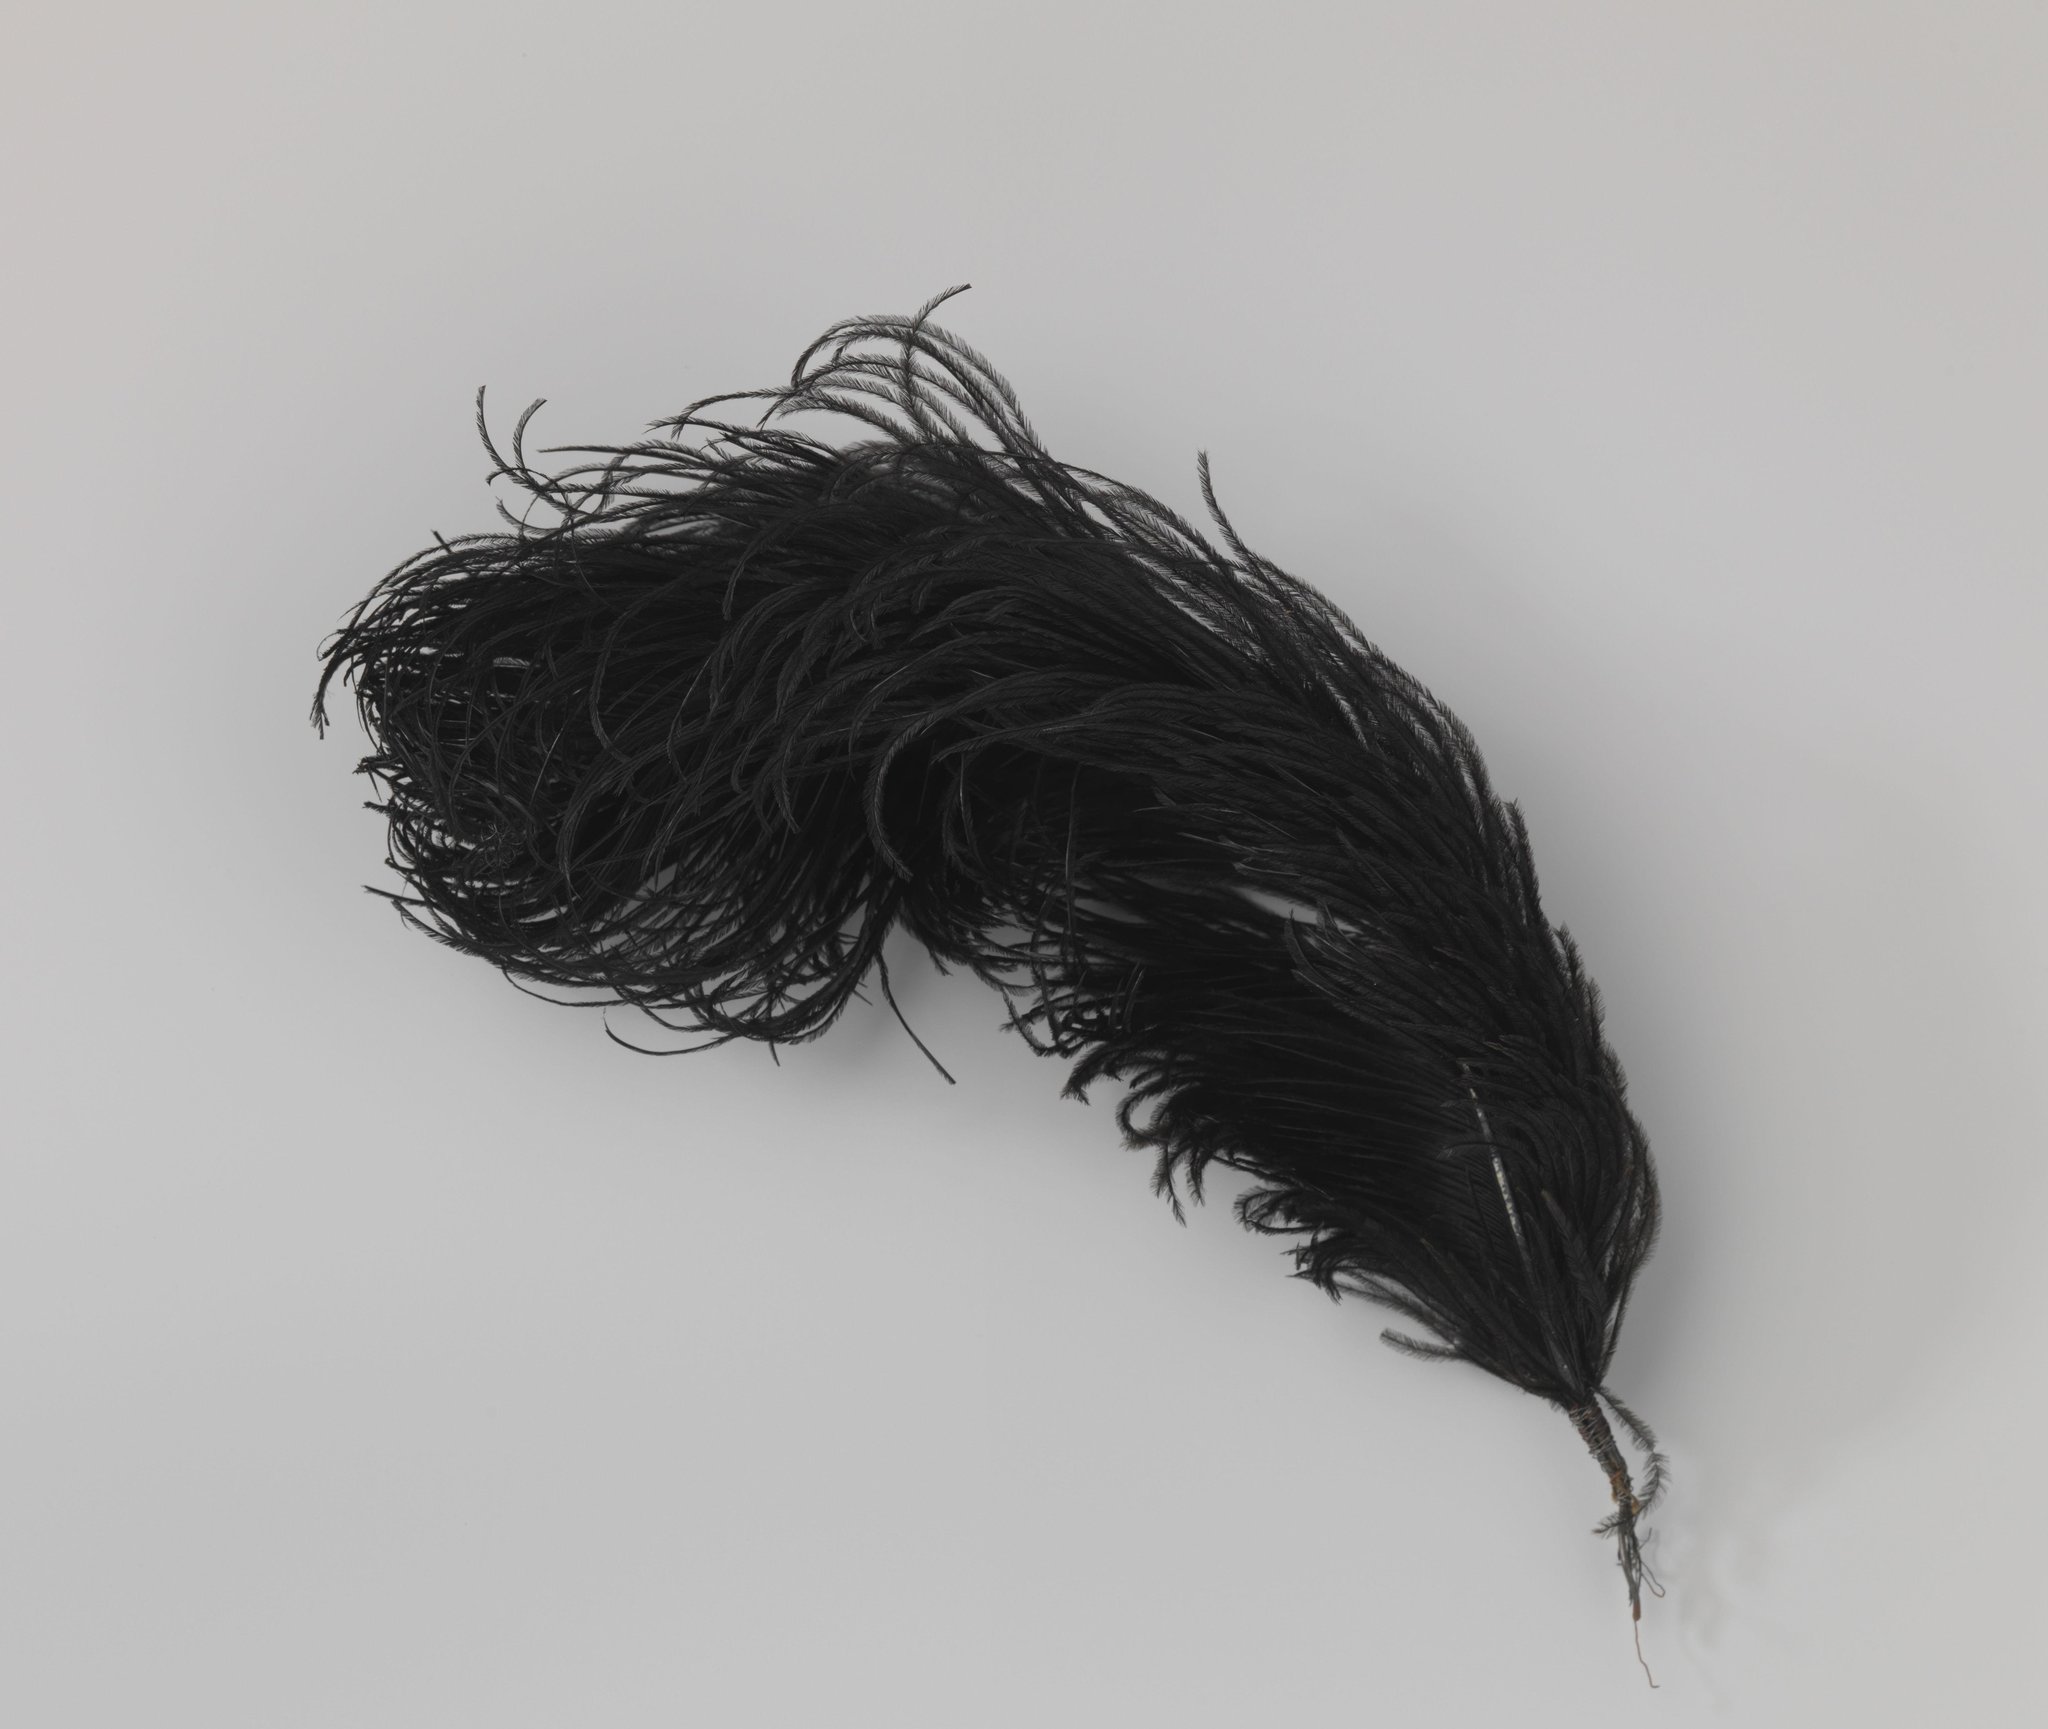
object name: hoedenveer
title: Struisveer, zwart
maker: Anonymous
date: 1880-1940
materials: metal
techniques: painting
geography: western europe